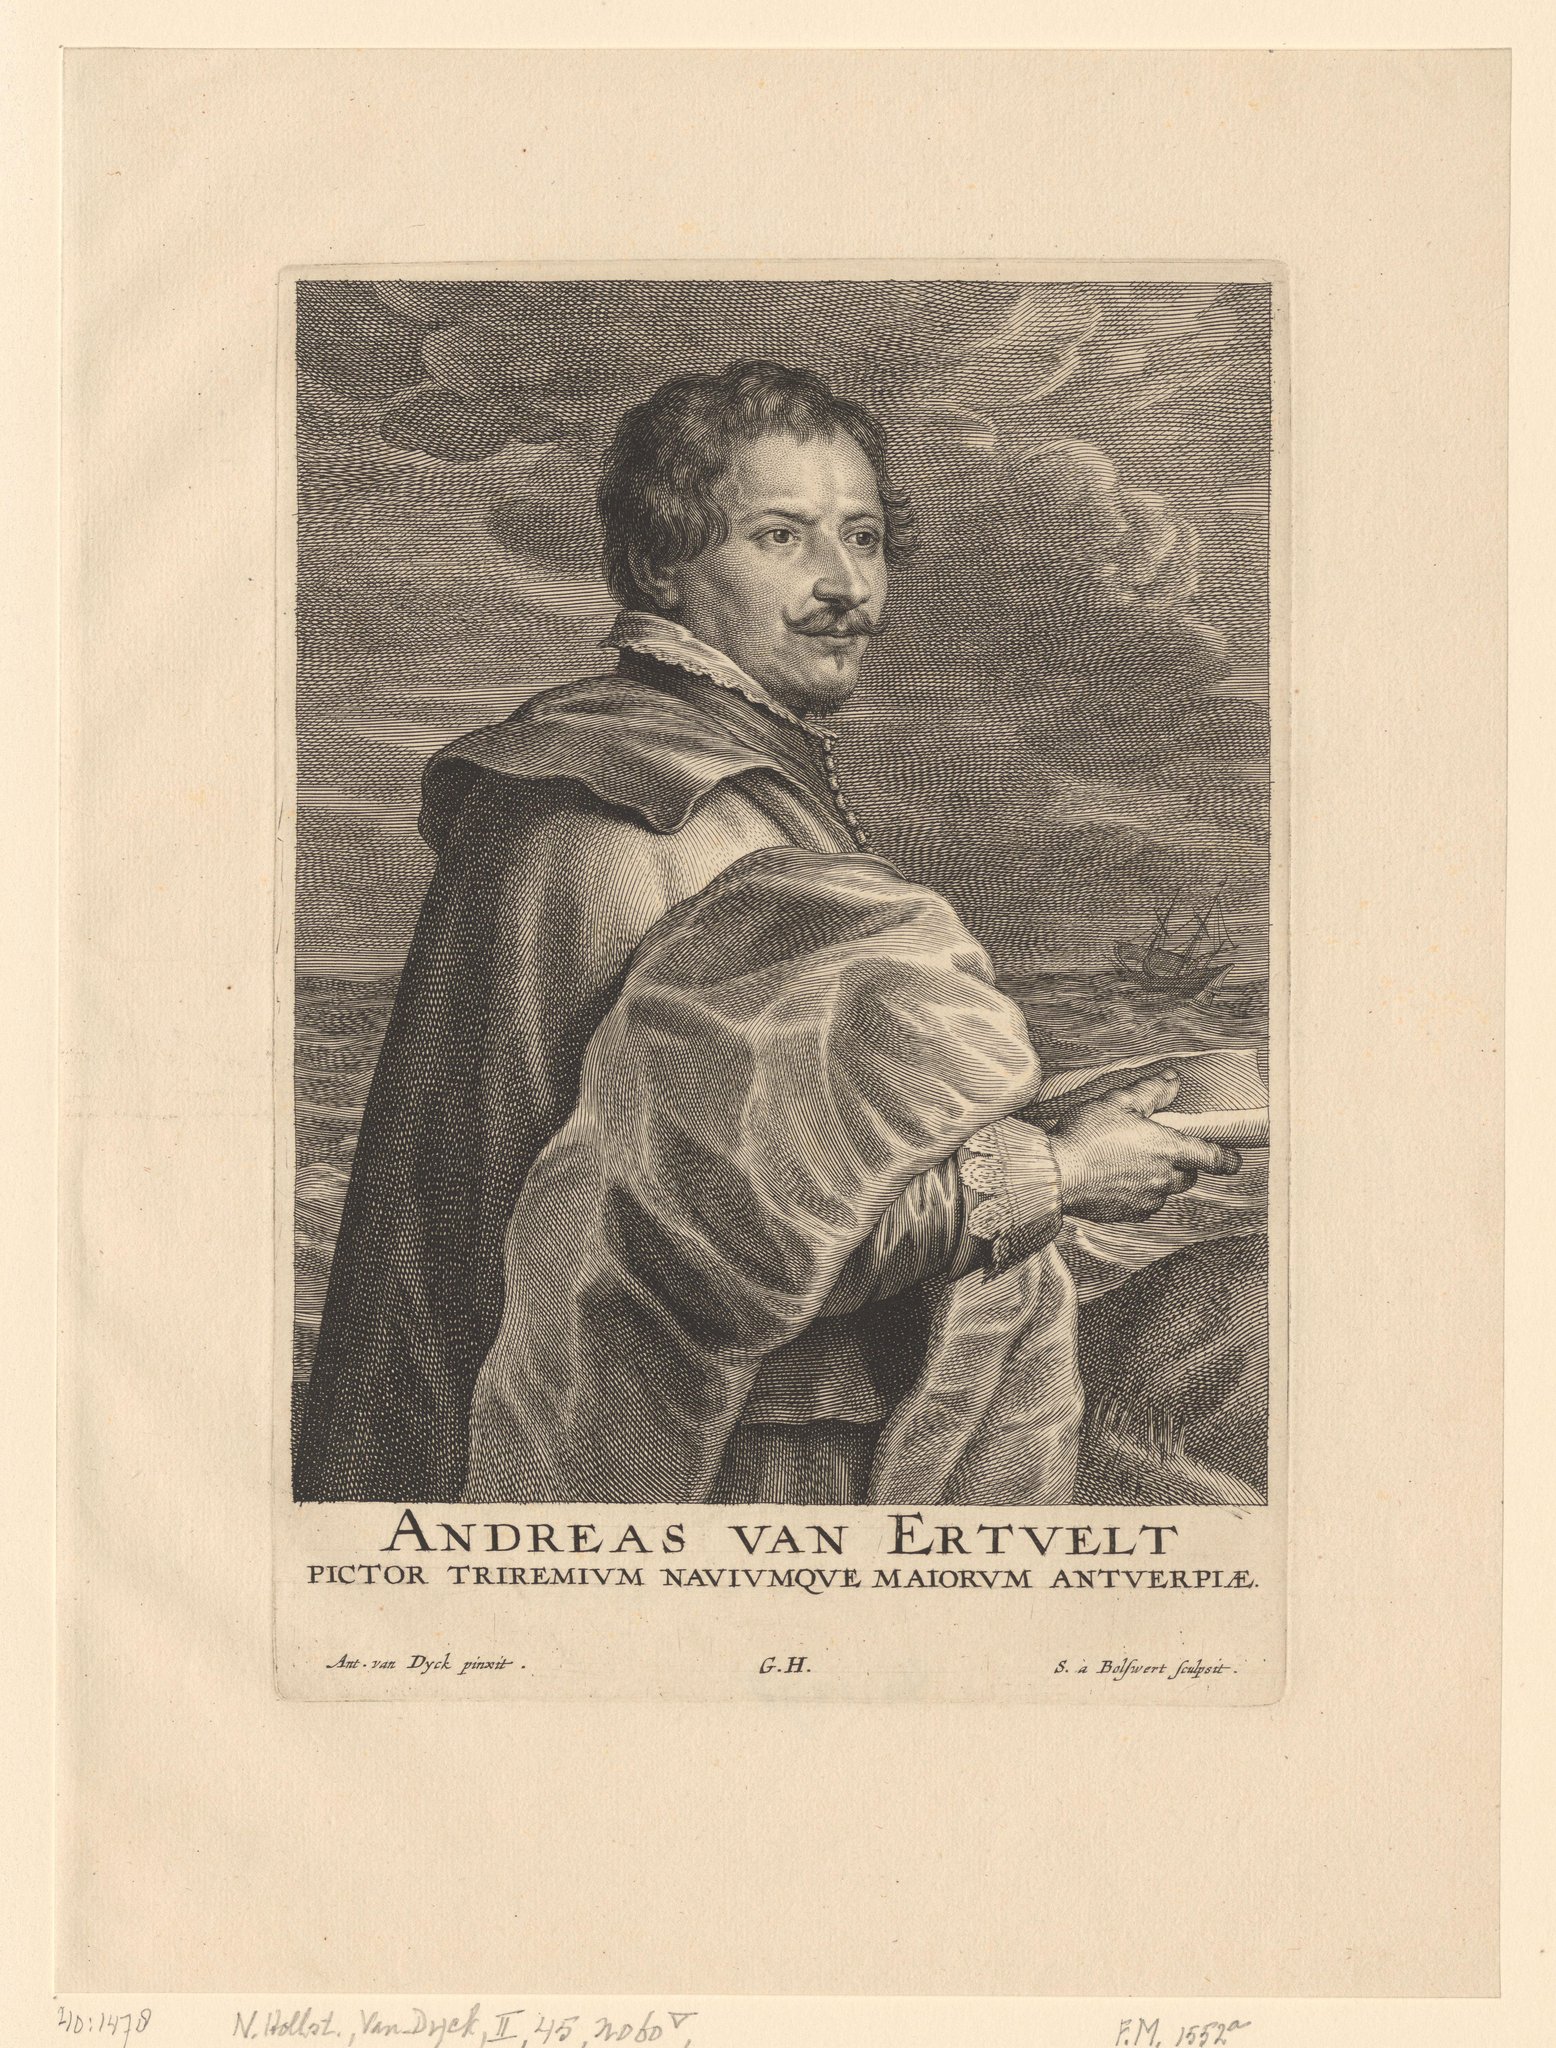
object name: print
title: Iconographie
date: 1645-1646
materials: paper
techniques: engraving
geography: antwerp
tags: antwerp, painter, draughtsman, andries van eertvelt, historical persons, ships (in general), portrait, self-portrait of painter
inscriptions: collector's mark: Lugt 2760, collector's mark: Lugt 2228, collector's mark: Lugt 2166